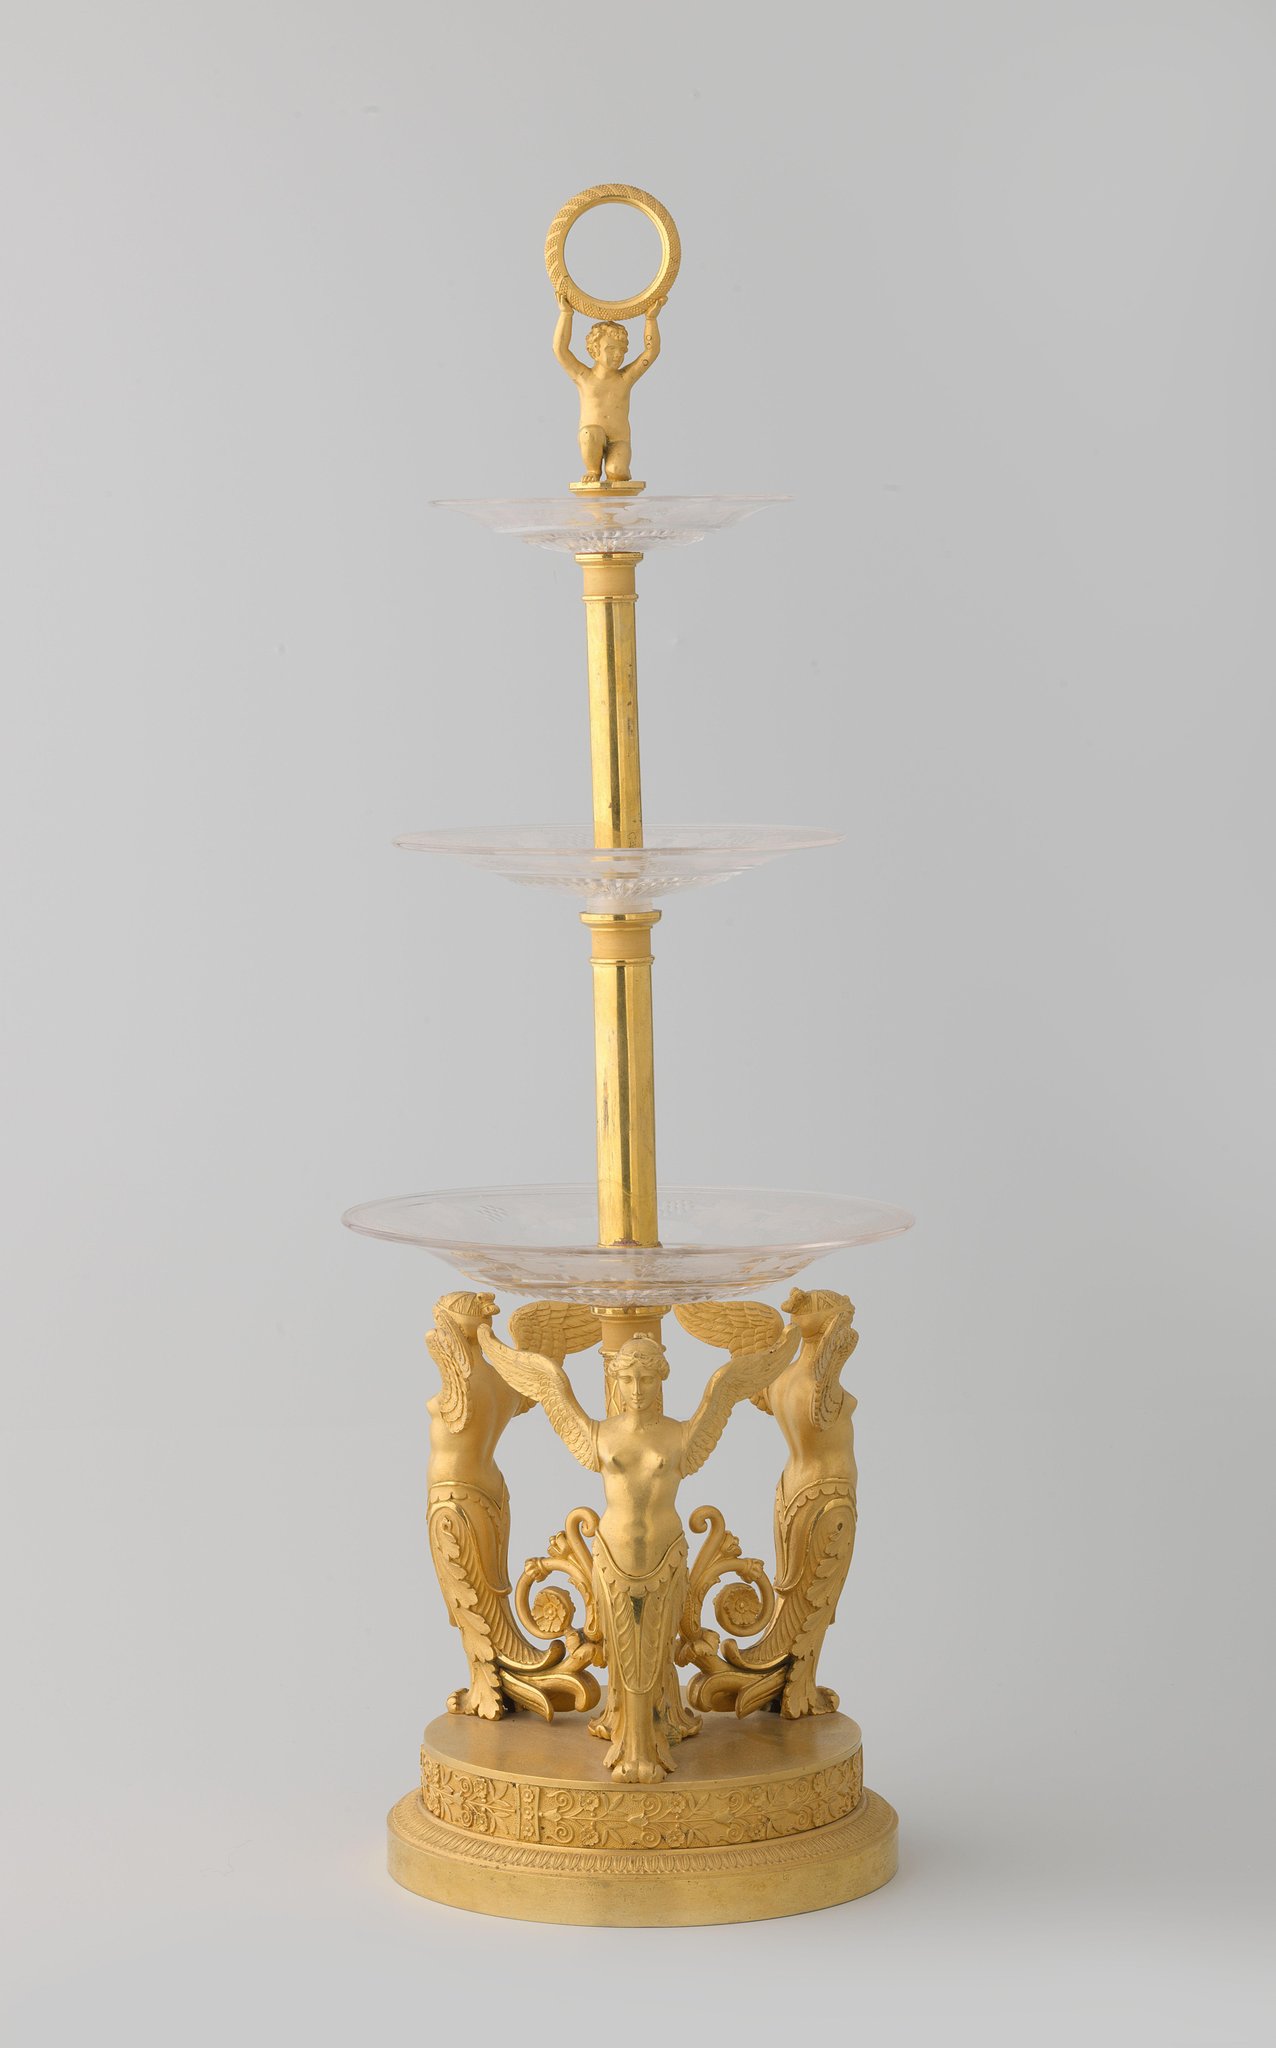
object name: eating drinking utensil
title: Tafelstuk van verguld brons en geslepen kristal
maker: pierre philippe thomire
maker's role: brazier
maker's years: 1751-1843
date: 1805-1815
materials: bronze, crystal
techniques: gilding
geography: paris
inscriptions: signature: ‘THOMIRE A PARIS’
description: Tafelstuk van verguld brons en geslepen kristal. De voet is versierd met bladwerk en rozetten. Op een dekplaat staan drie afgewende gevleugelde vrouwenfiguren, oprijzend uit acanthusgebladerte en eindigend in bladranken met rozetten. De stam heeft een basis van bladeren en is bewerkt met puntig bladwerk, waarboven een kapiteel. De stam draagt drie kristallen schaaltjes van opeenvolgend formaat, versierd met wingerdranken en gescheiden door twee gladde zuilen. Bovenop een geknielde putto met krans. Zie: a/g.